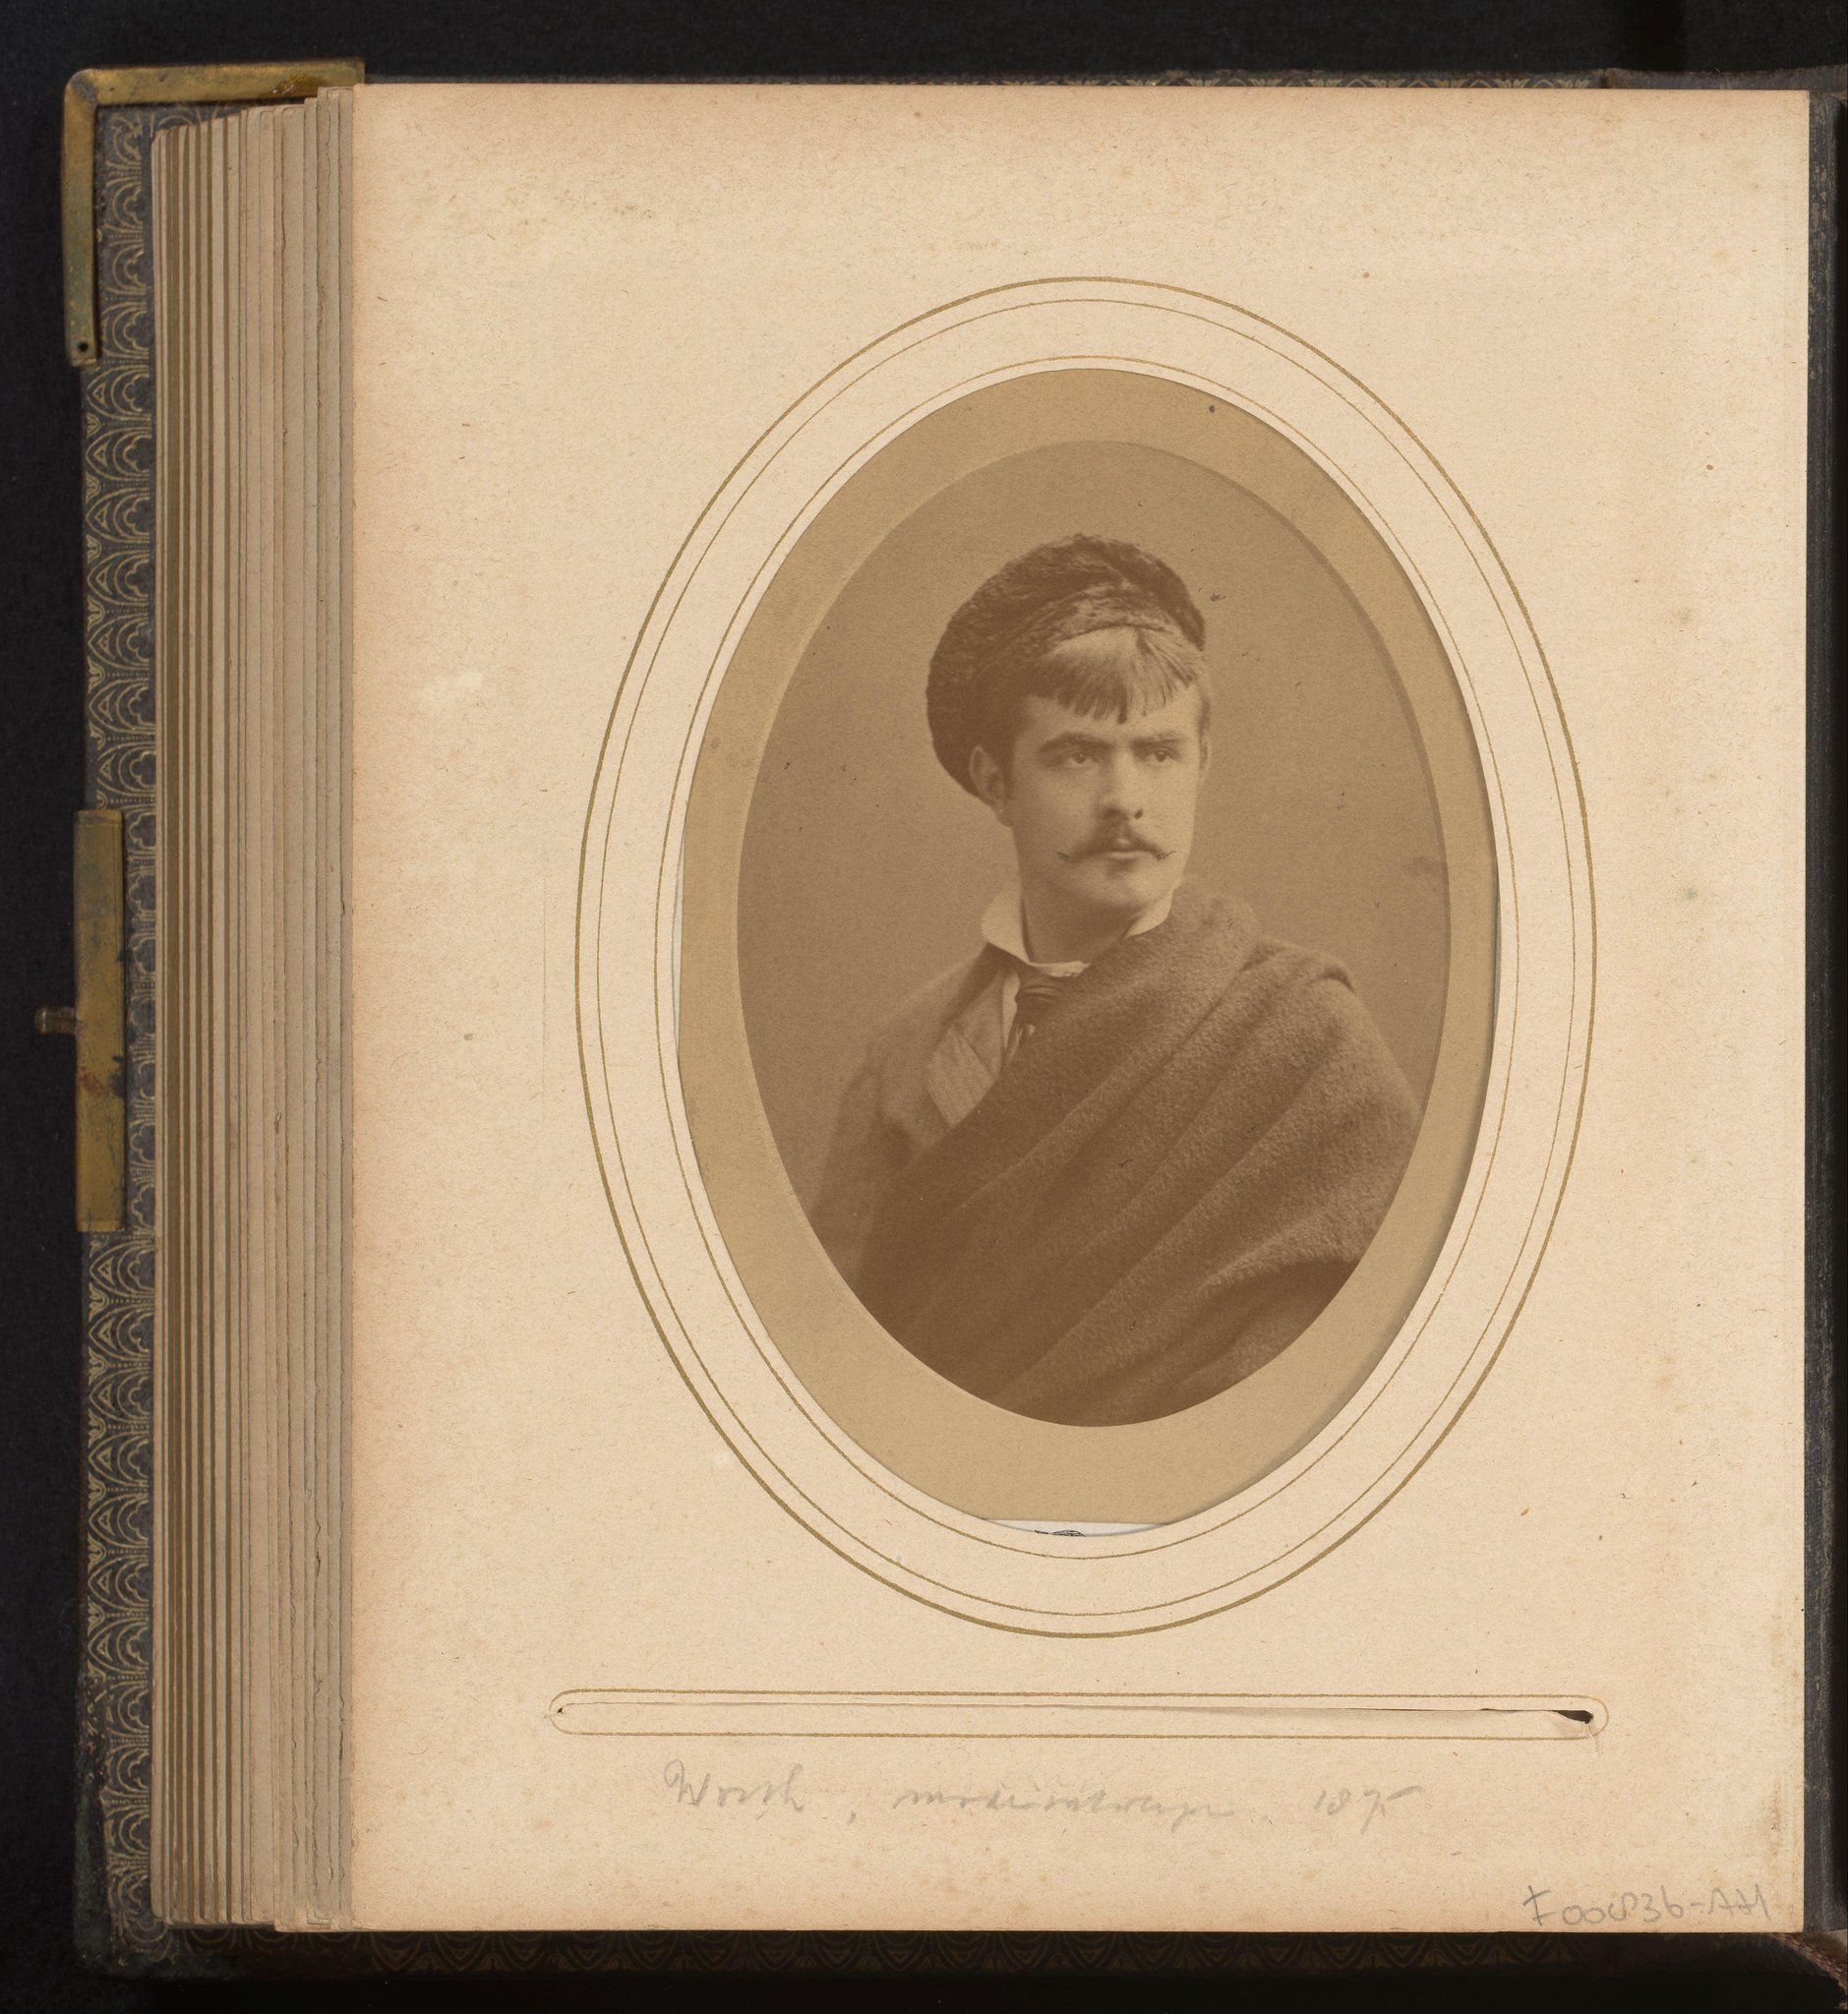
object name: cabinet photograph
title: Portret van Gaston of Jean-Philippe Worth, modeontwerper te Parijs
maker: charles reutlinger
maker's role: publisher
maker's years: 1816-1880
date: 1875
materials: cardboard, photographic support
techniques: albumen print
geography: paris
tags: fashion designer, historical persons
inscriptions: inscription: ‘Ch. Reutlinger/ Photographe/ 21, Boulevard Montmartre, 21/ Paris’, date: ‘1875 7/12/ Monsieur Worth’, annotation: ‘Worth, montmartre 1875’